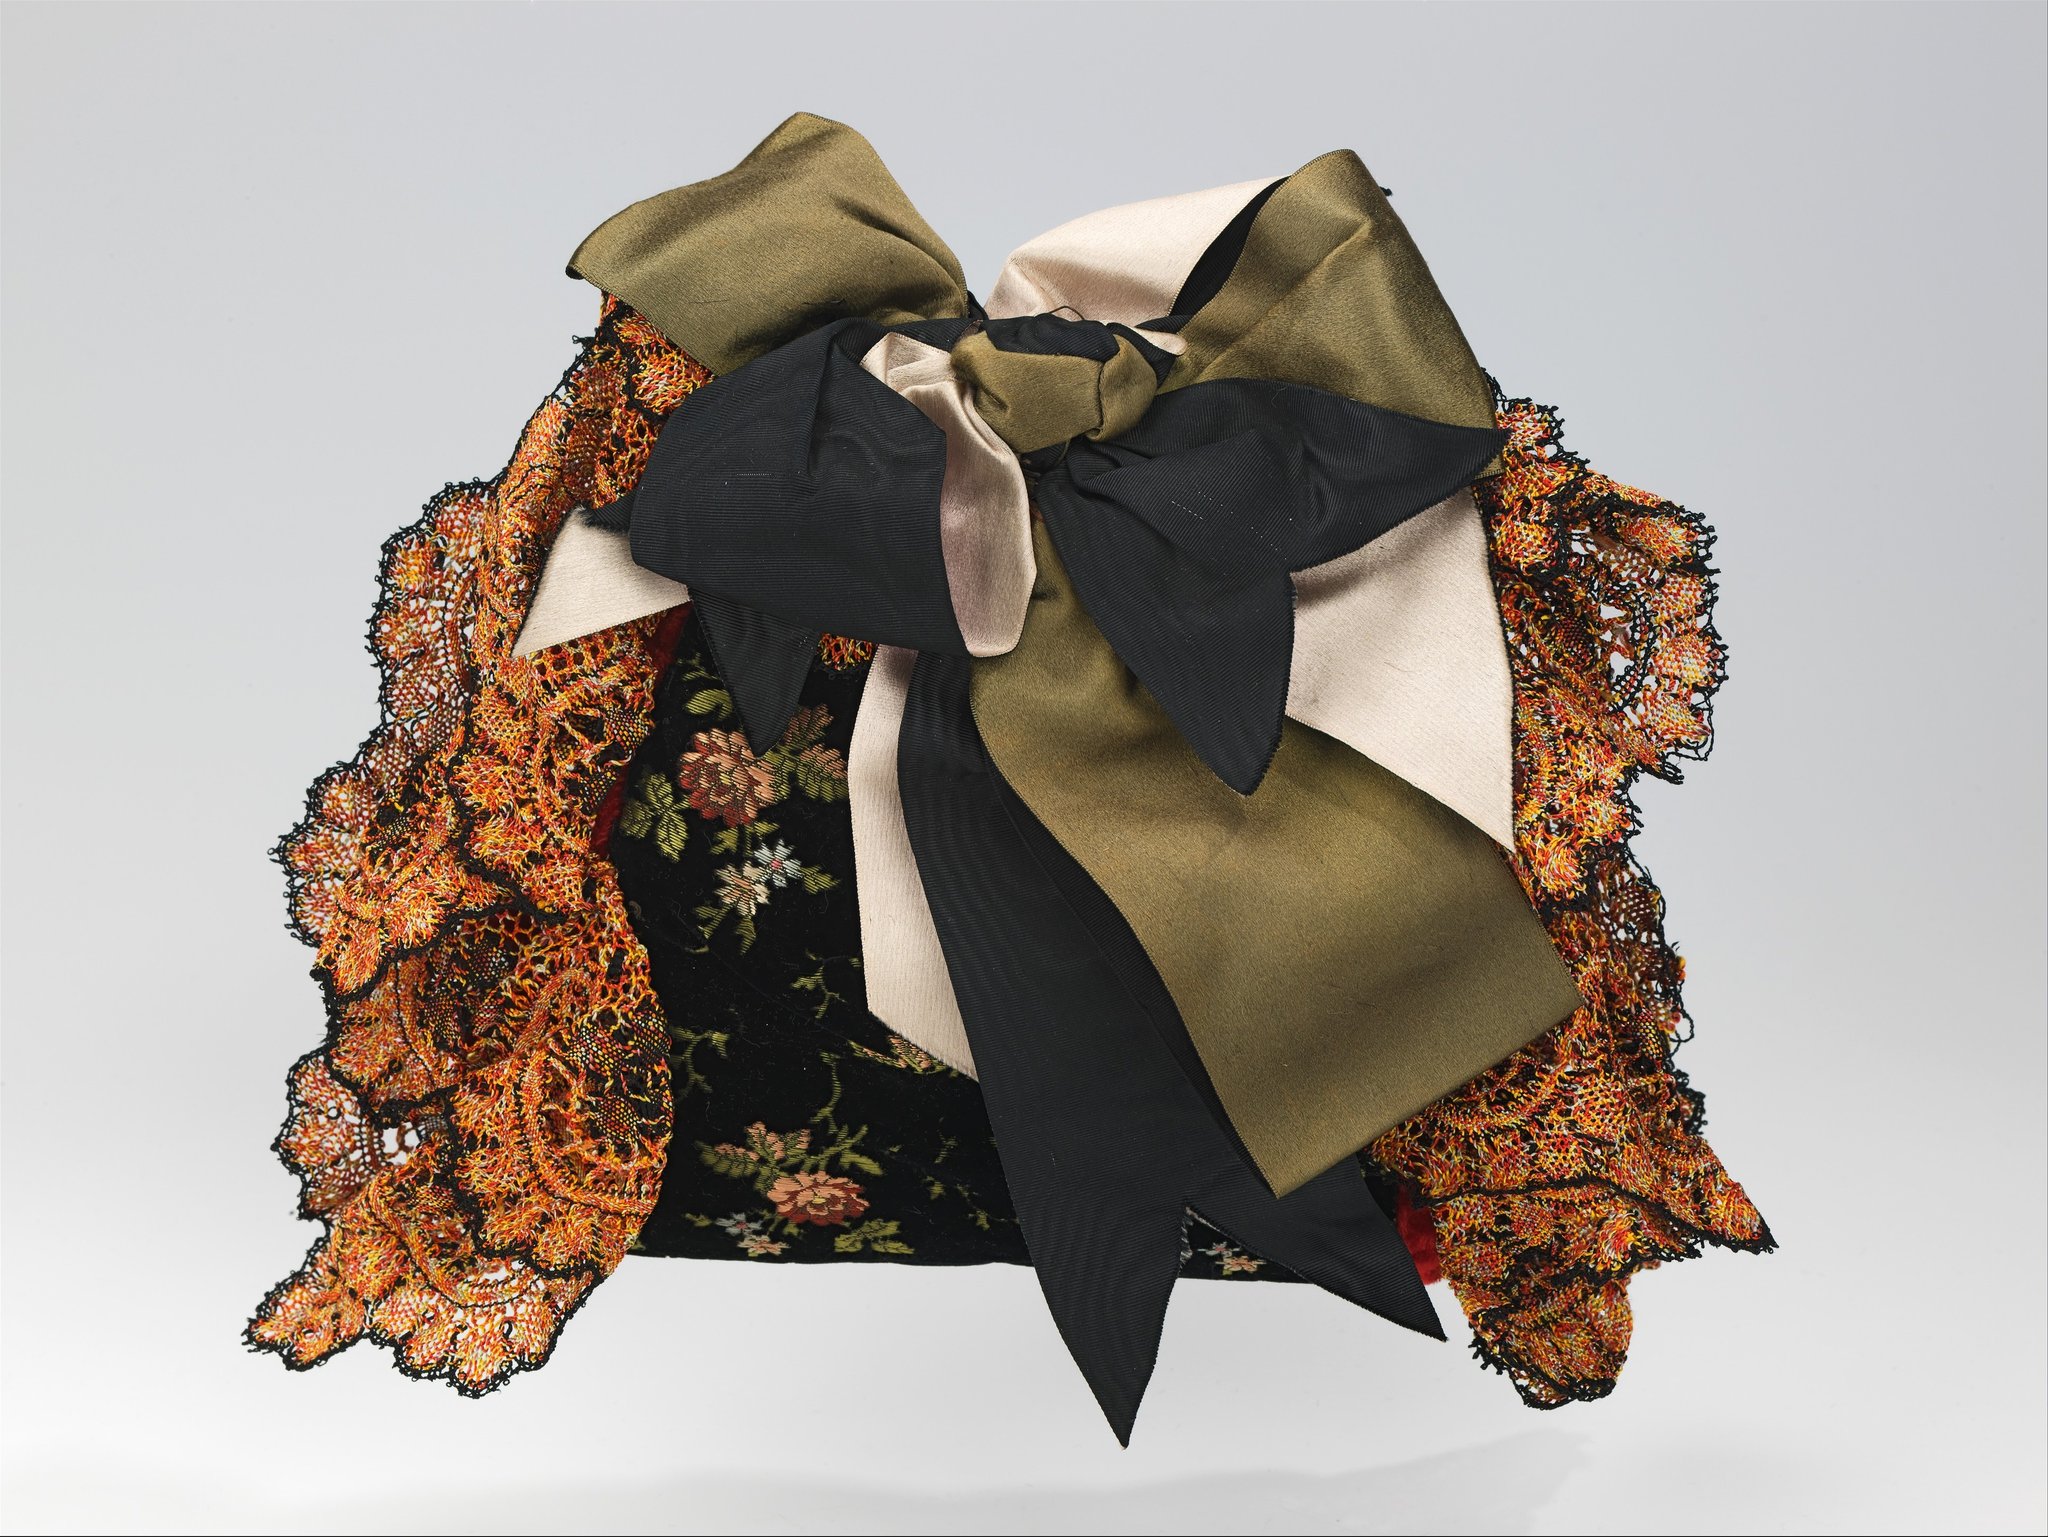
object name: evening muff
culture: french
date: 1876-1900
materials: silk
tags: flowers